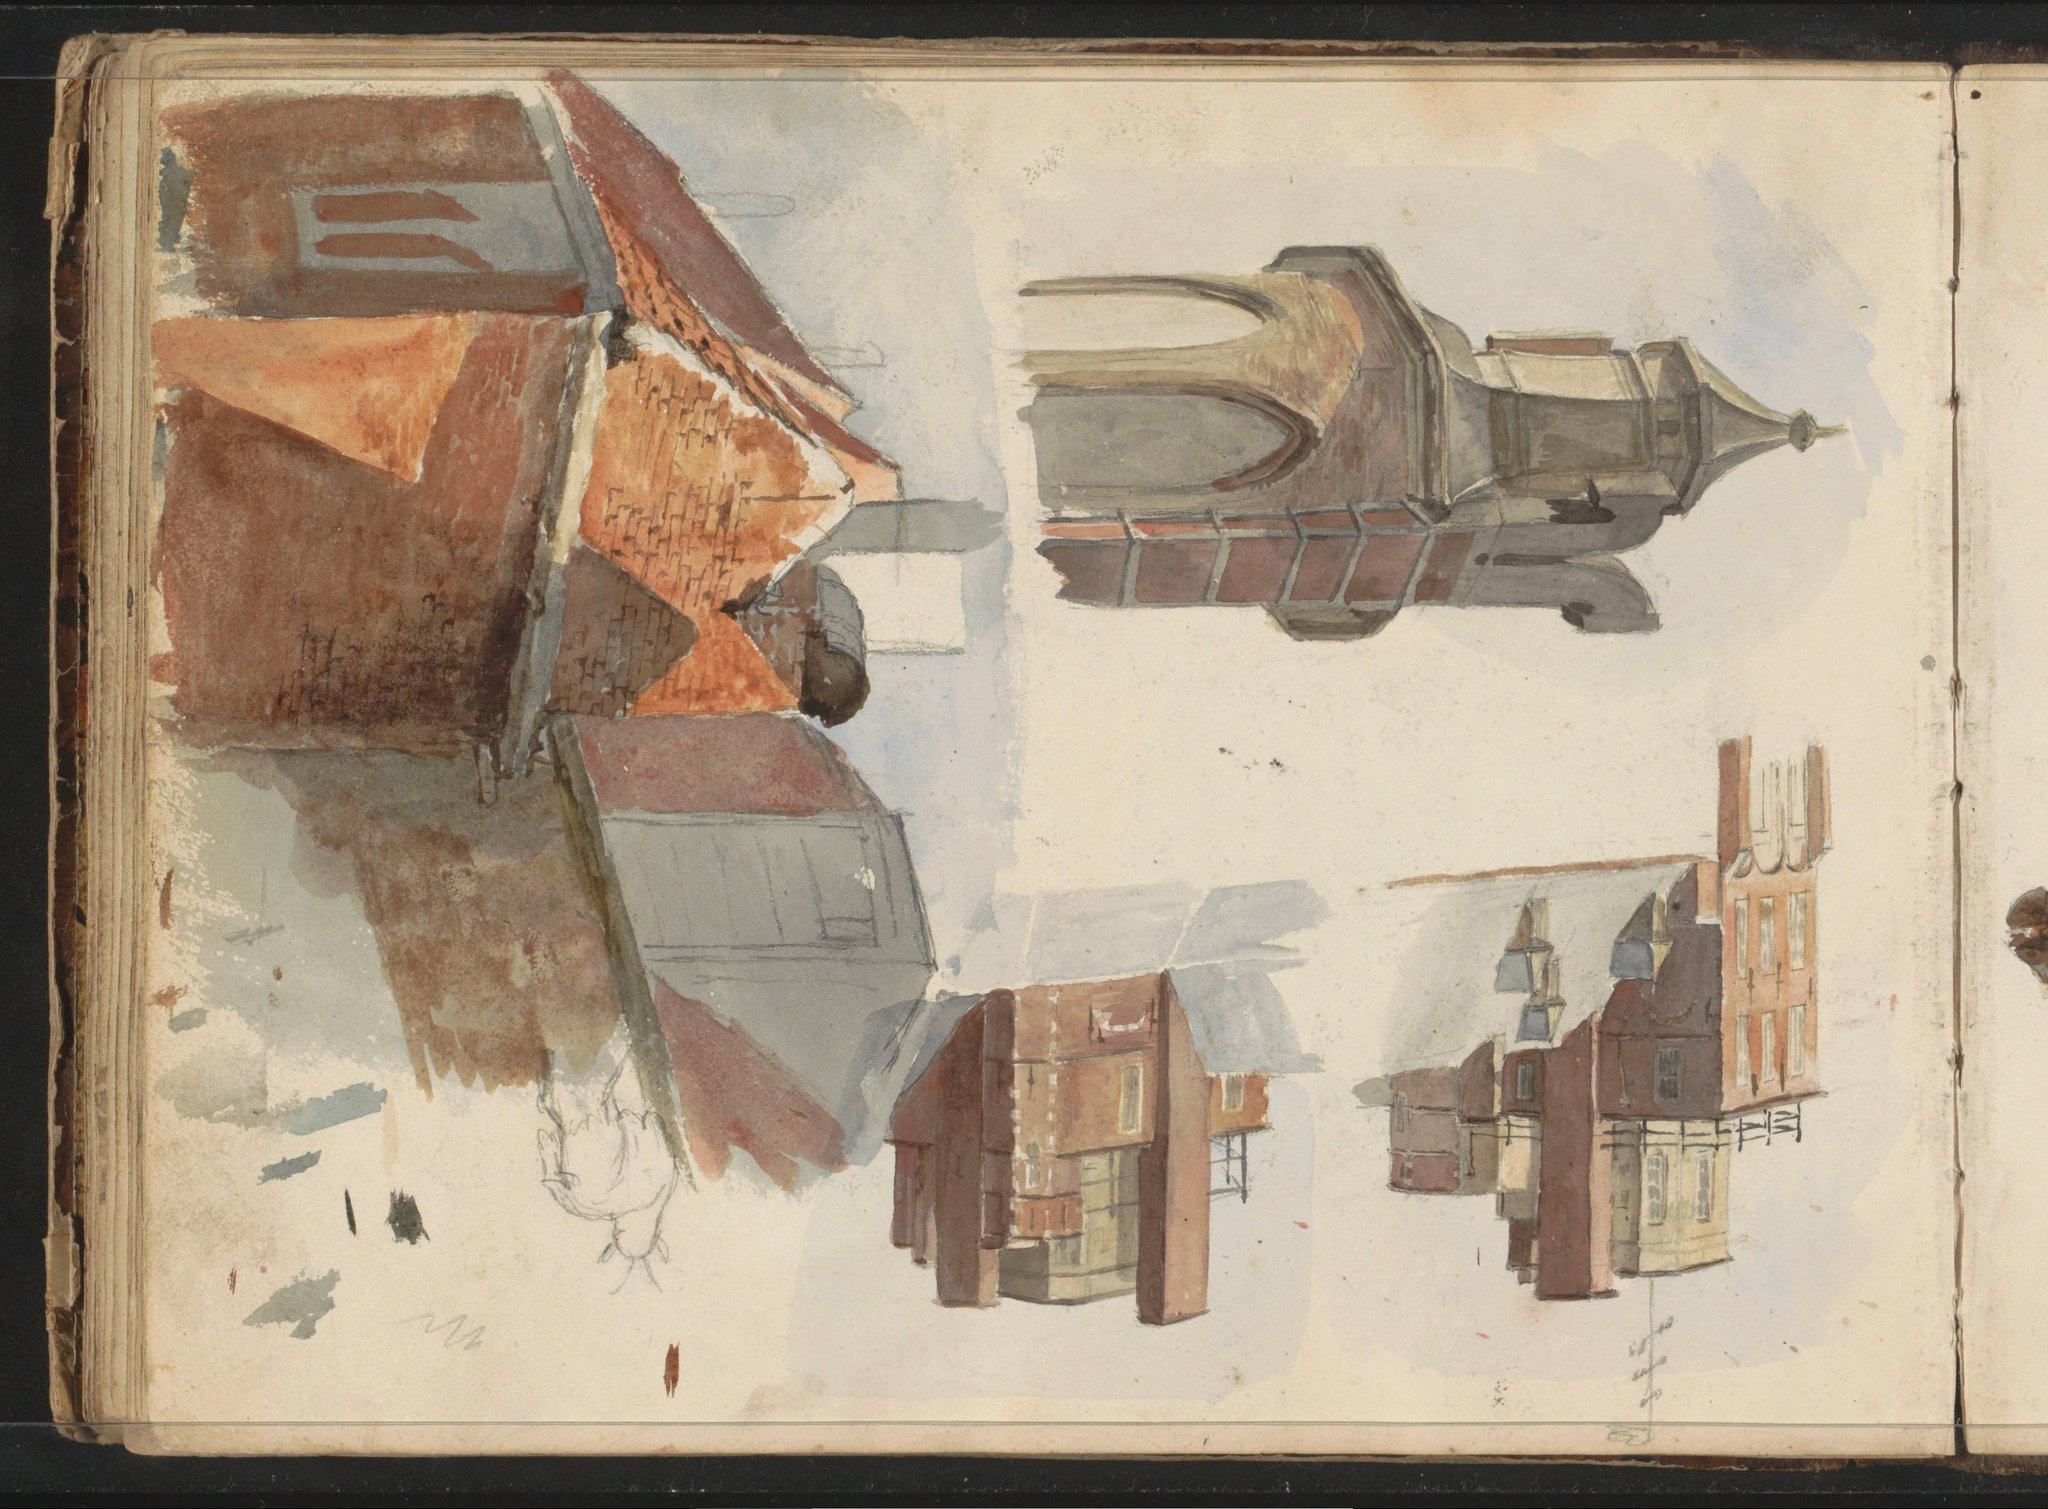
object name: sketchbook leaf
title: Details van architectuur aan het Buitenhof te Den Haag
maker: willem troost (ii)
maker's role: draughtsman, painter, print maker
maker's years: 1812-1893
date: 1822-1893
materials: paper, pencil, watercolor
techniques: brush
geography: the hague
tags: roof (of house or building), spire (of tower on house or building), architecture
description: Tevens een studie van een geit. Blad 60 verso uit een schetsboek met 36 bladen.